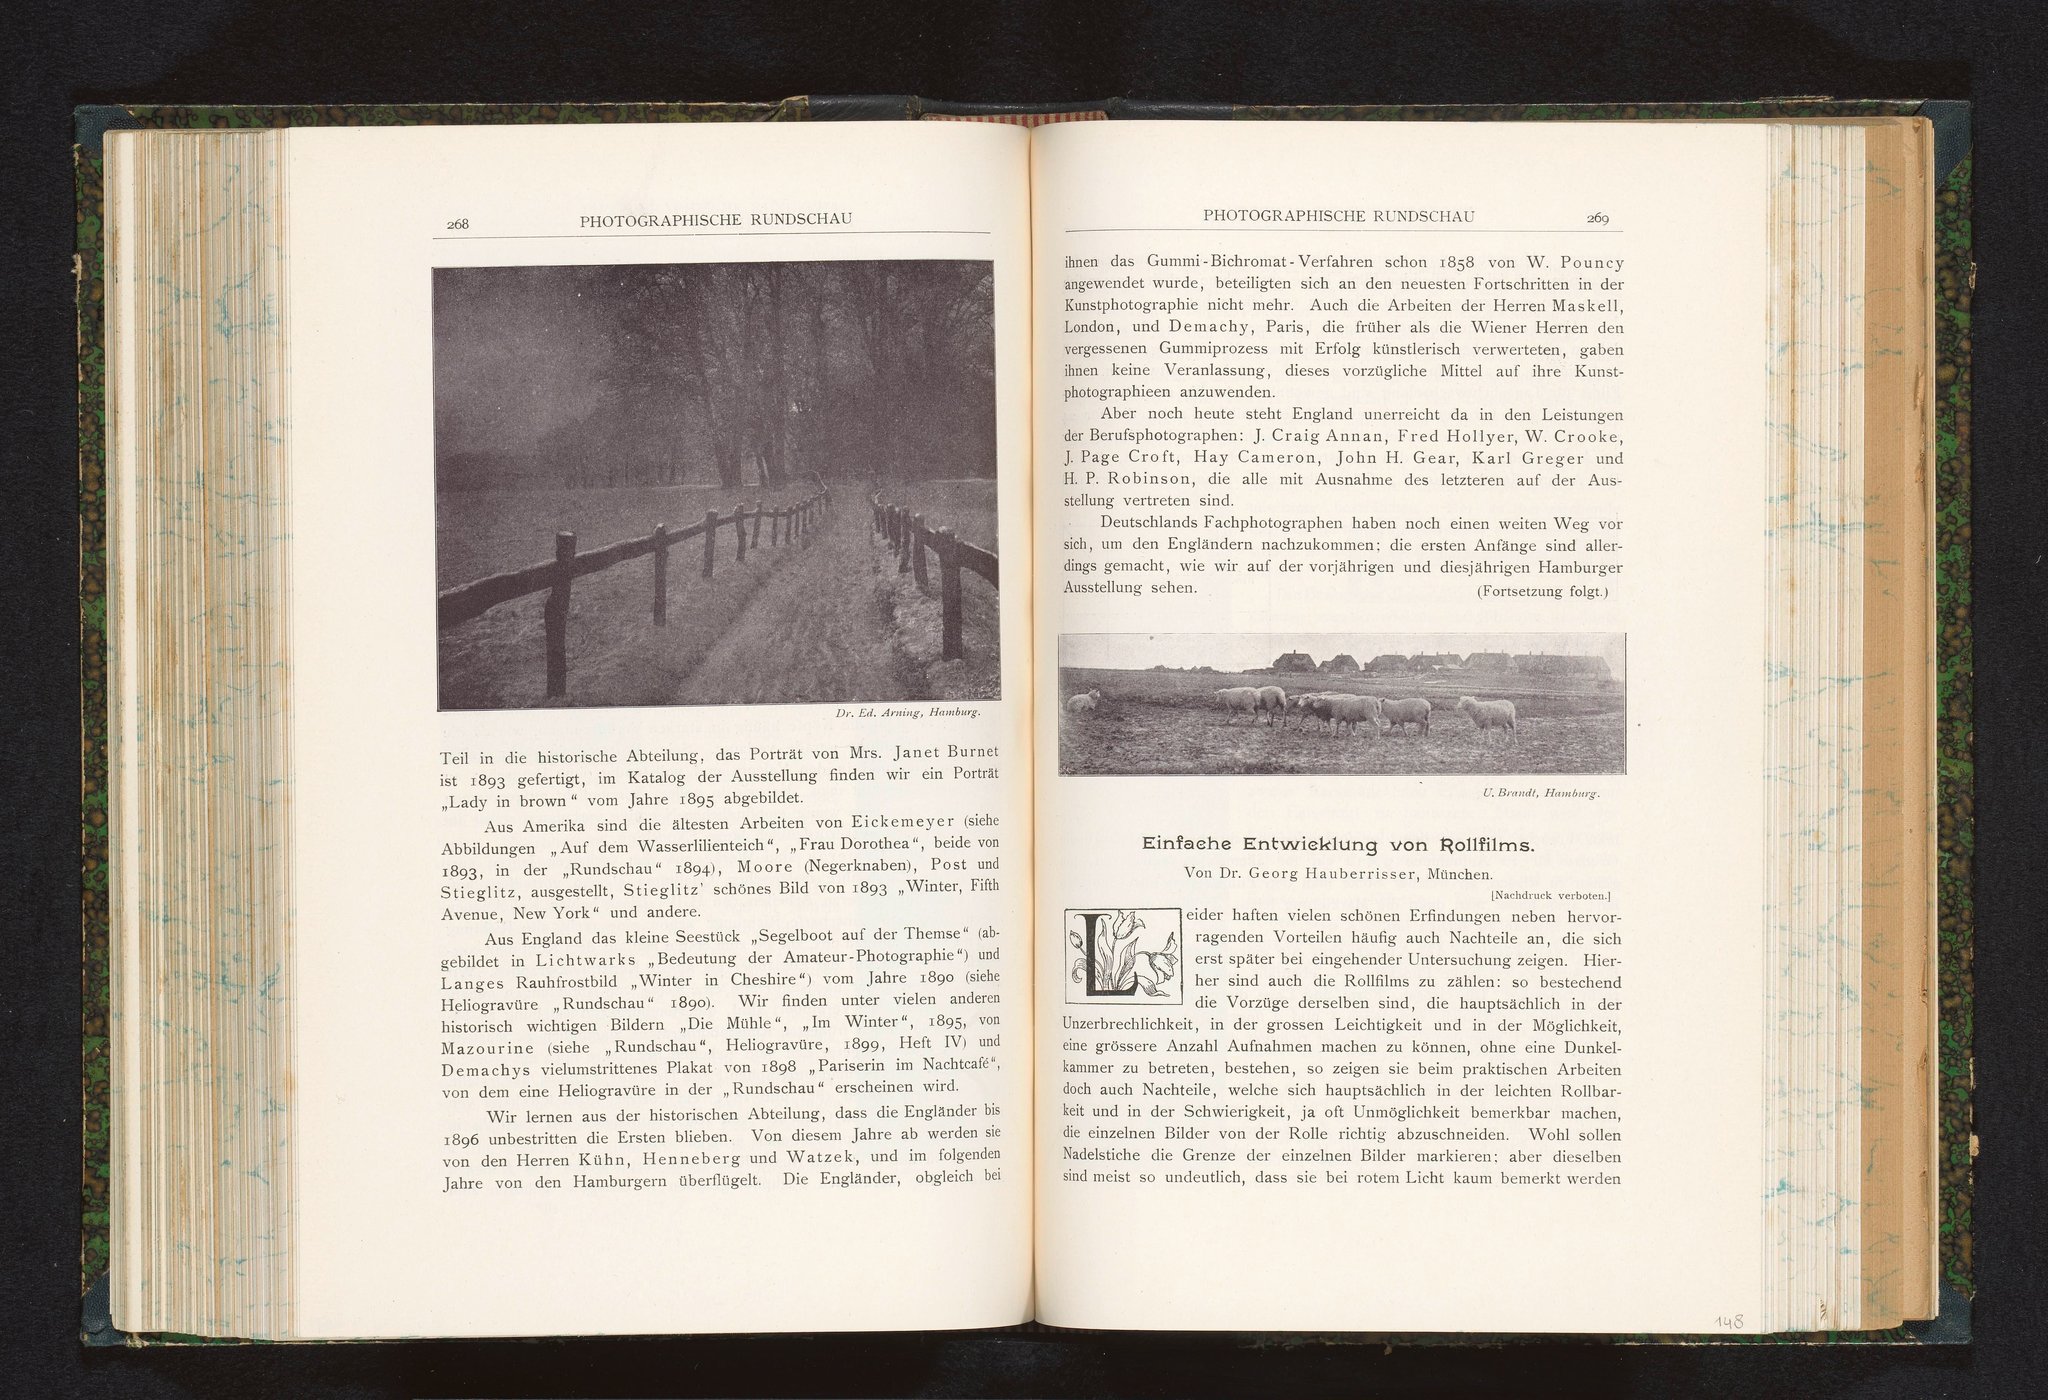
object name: photomechanical print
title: Twee weilanden met omheining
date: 1894-1899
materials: paper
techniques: autotype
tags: fence, wall, paling, meadow, pasture